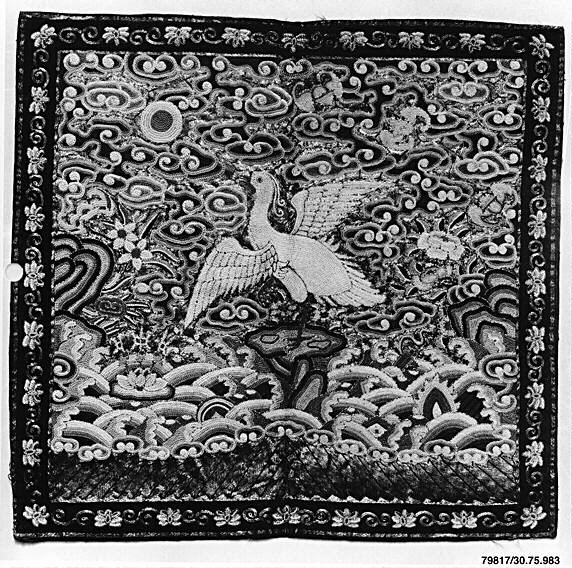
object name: rank badge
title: Rank Badge with Egret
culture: chinese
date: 1767-1800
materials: metal thread, silk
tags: bats,birds